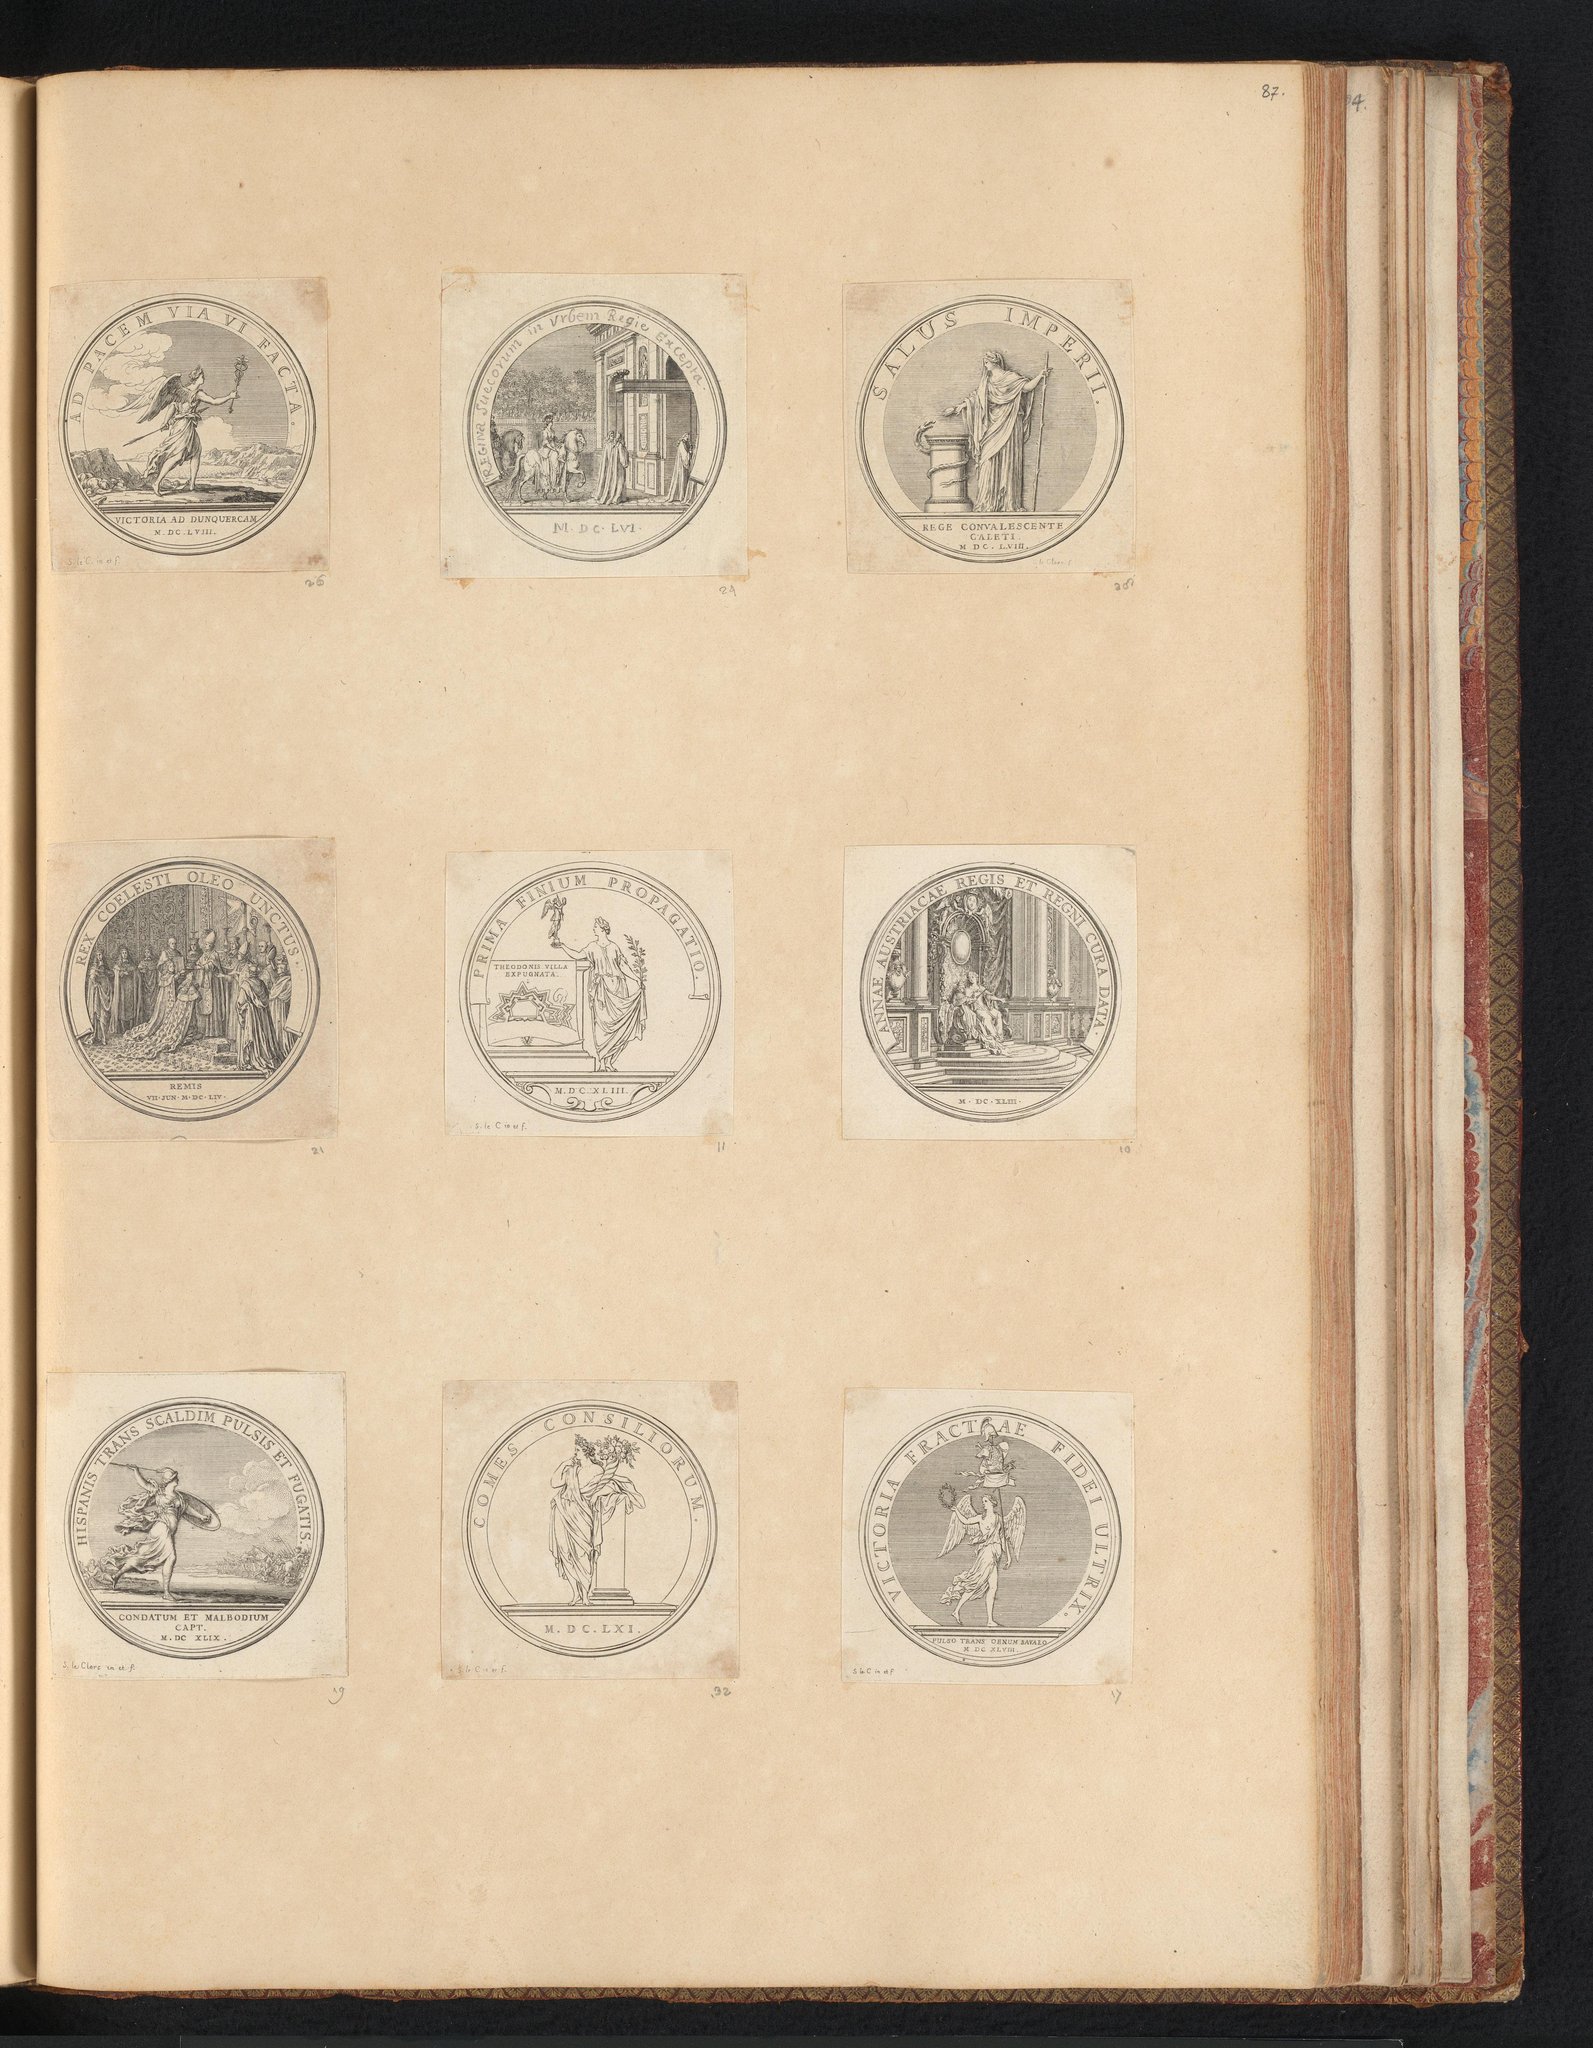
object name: album leaf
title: Negen medailles ter ere van Lodewijk XIV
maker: sébastien leclerc (i)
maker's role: print maker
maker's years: 1637-1714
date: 1702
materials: paper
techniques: etching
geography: paris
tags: paris, anna van oostenrijk (koningin van frankrijk), rome, christina (koningin van zweden), lodewijk xiv (koning van frankrijk), (story of) pallas, personifications of countries, nations, states, districts, etc., historical persons, queen, medal (considered as a piece of sculpture, regardless of its specific function), victory, king, health, 'sanitas'; 'sanità' (ripa) - aa - female human figure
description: Prenten bestemd voor: Médailles sur les principaux événements du règne de Louis le Grand. Parijs: Imprimerie Royale, 1702. Zes prenten niet gepubliceerd.